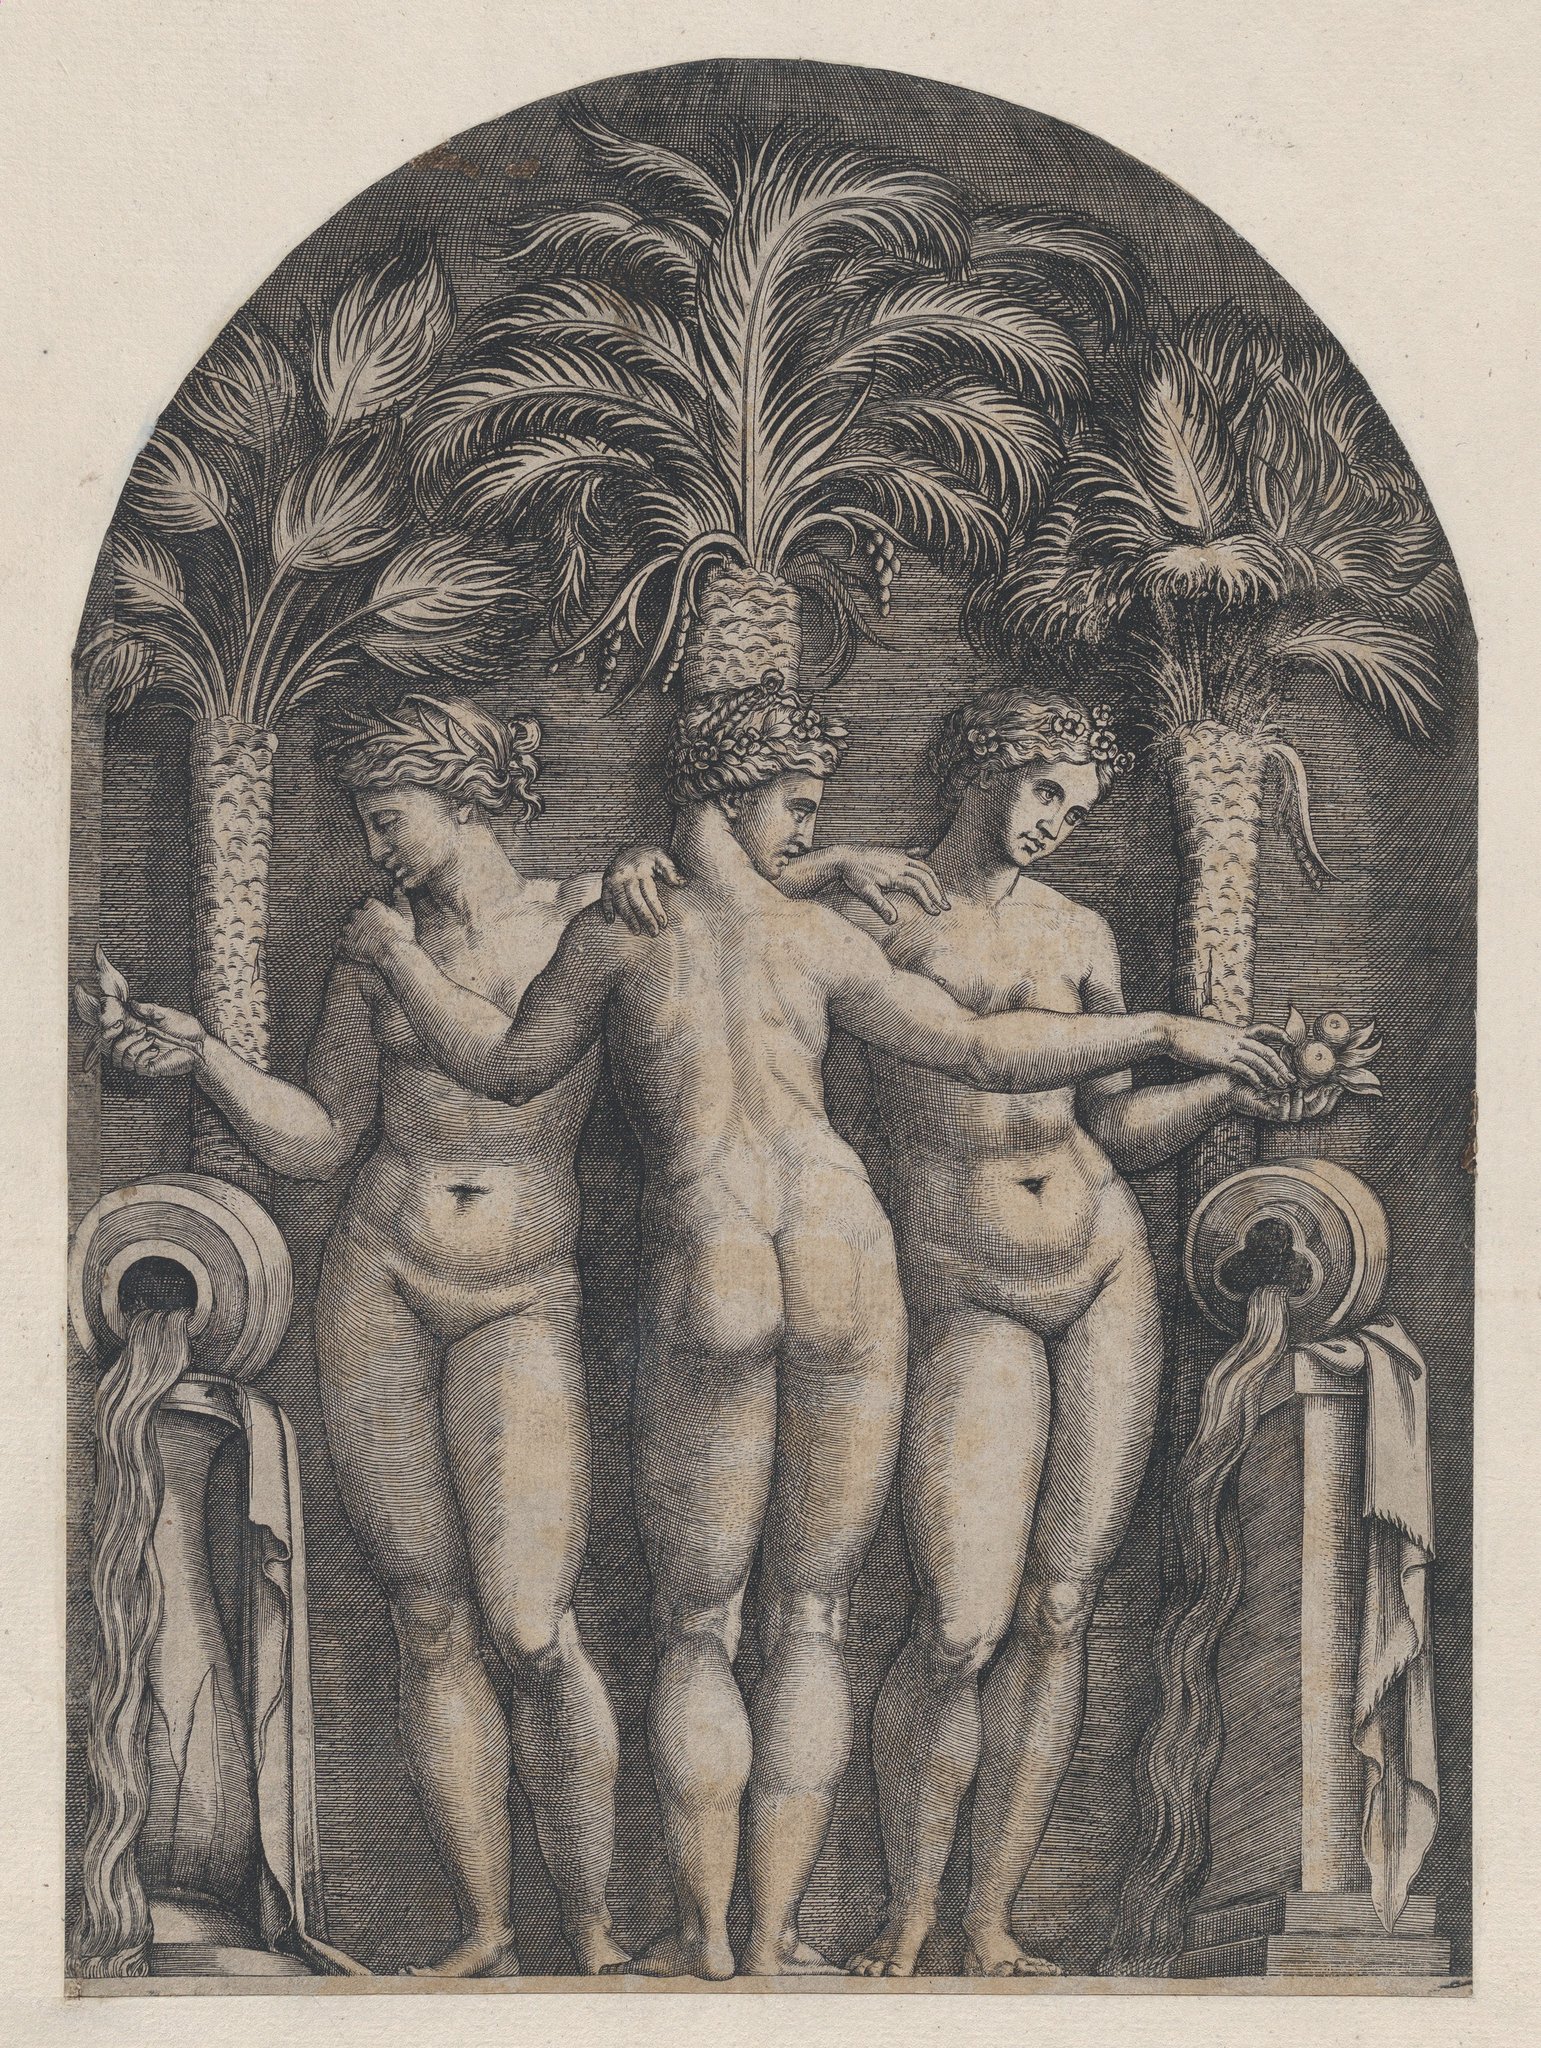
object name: print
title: The Three Graces, from "Speculum Romanae Magnificentiae"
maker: marcantonio raimondi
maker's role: artist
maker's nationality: italian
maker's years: 1475-1534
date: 1500-1534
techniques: engraving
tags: female nudes,trees